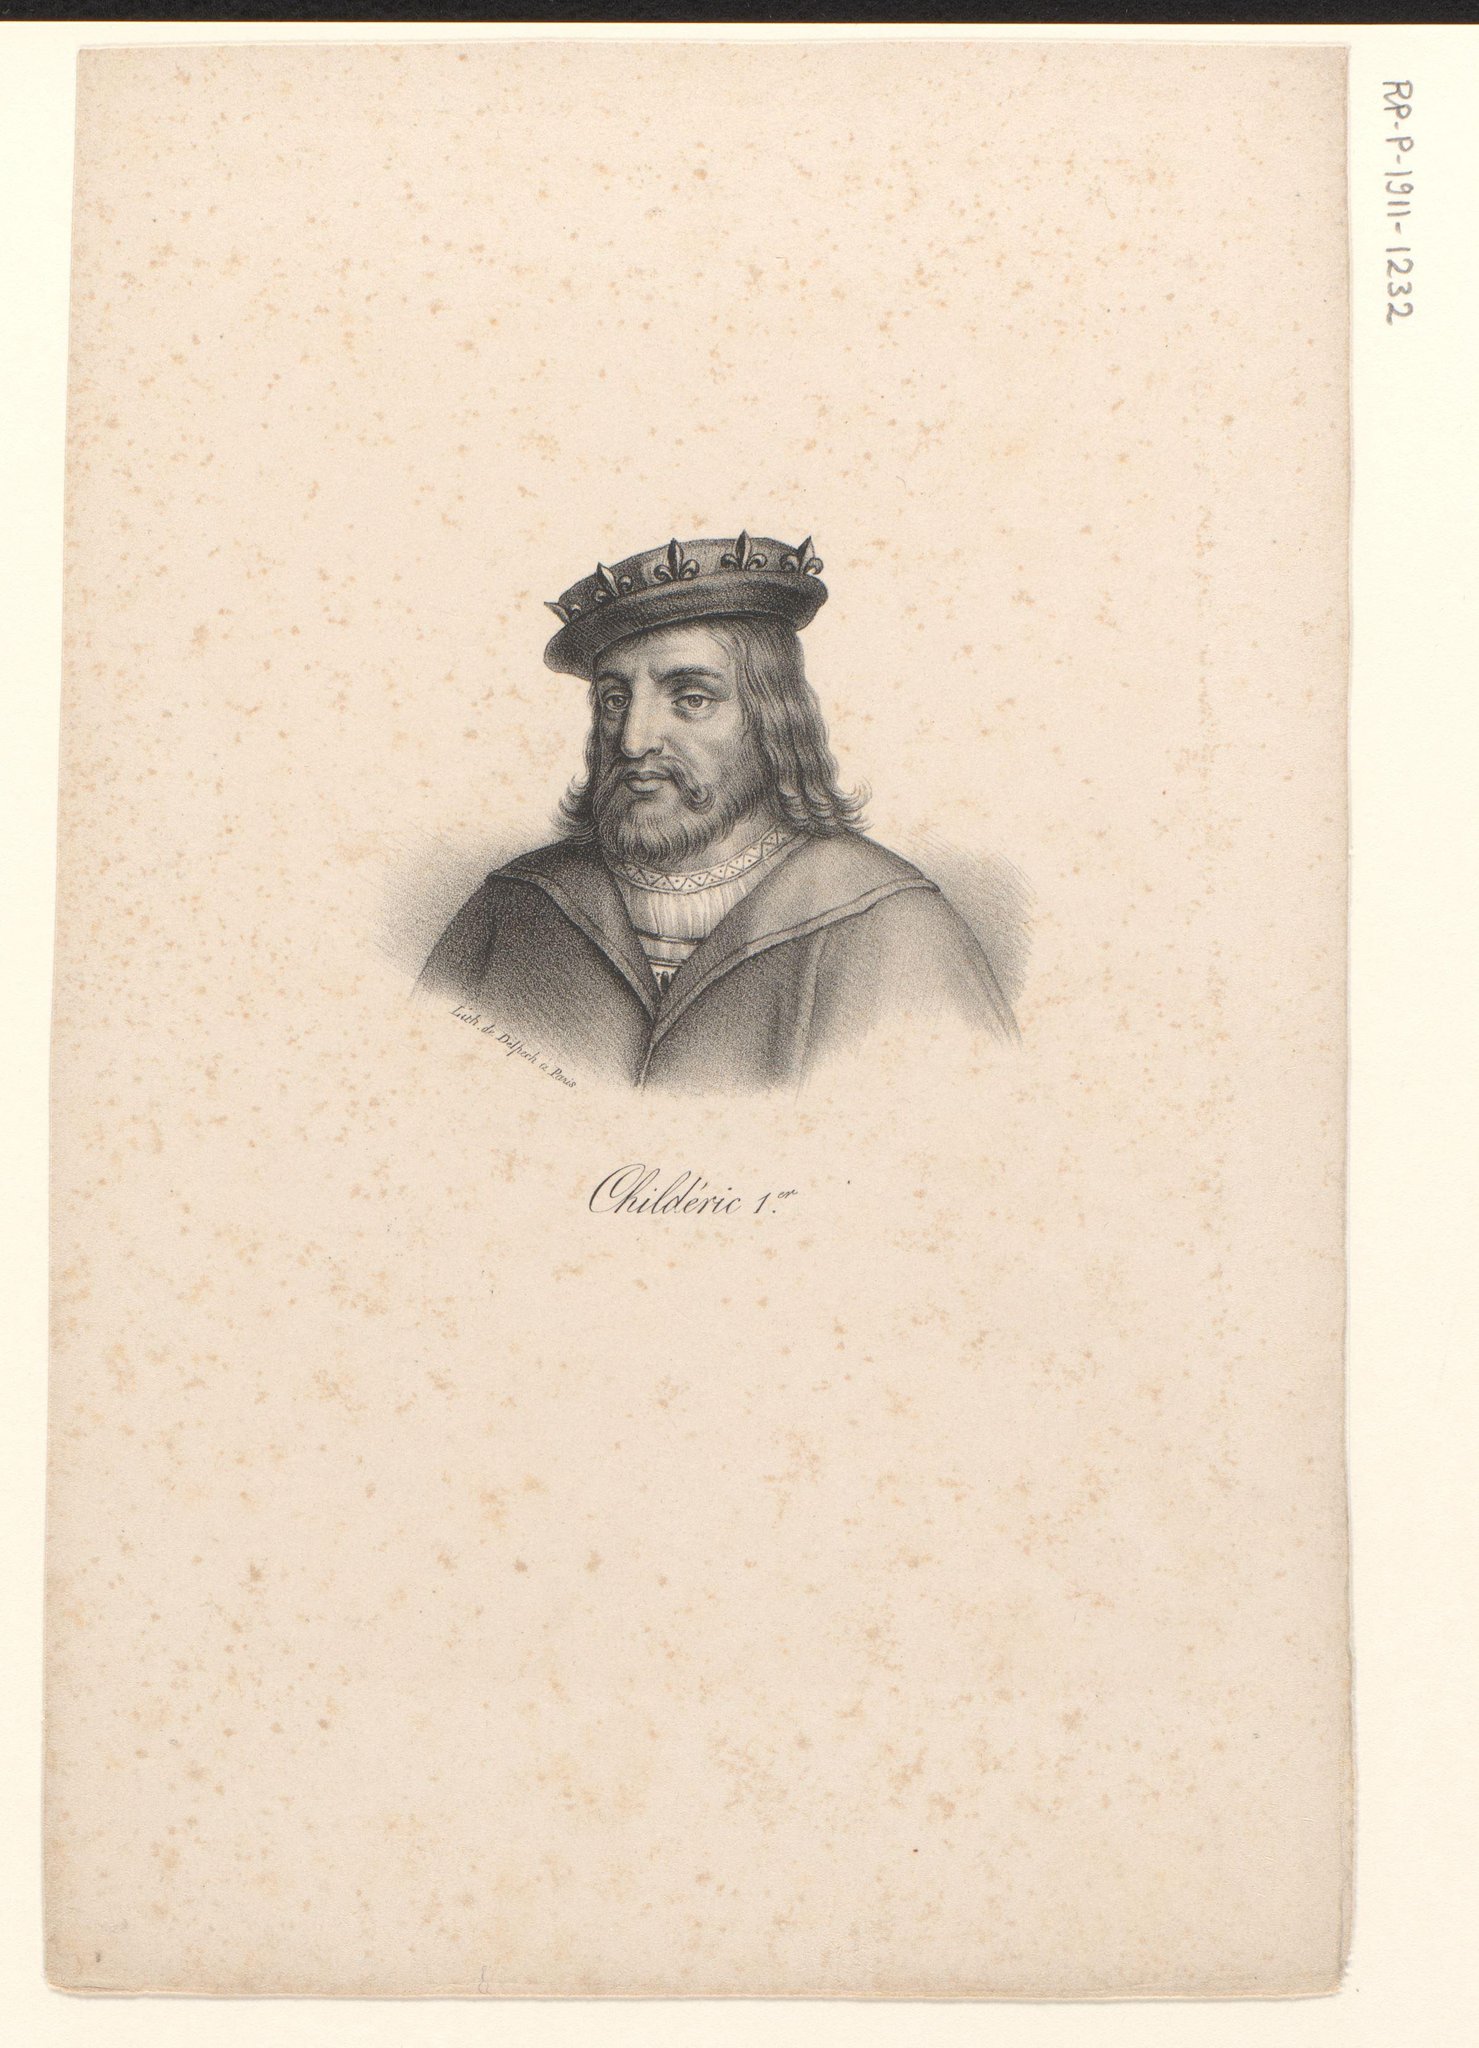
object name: print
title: Childéric 1er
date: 1818-1842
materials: paper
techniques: lithograph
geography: paris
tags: historical persons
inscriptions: collector's mark: Lugt 2228a